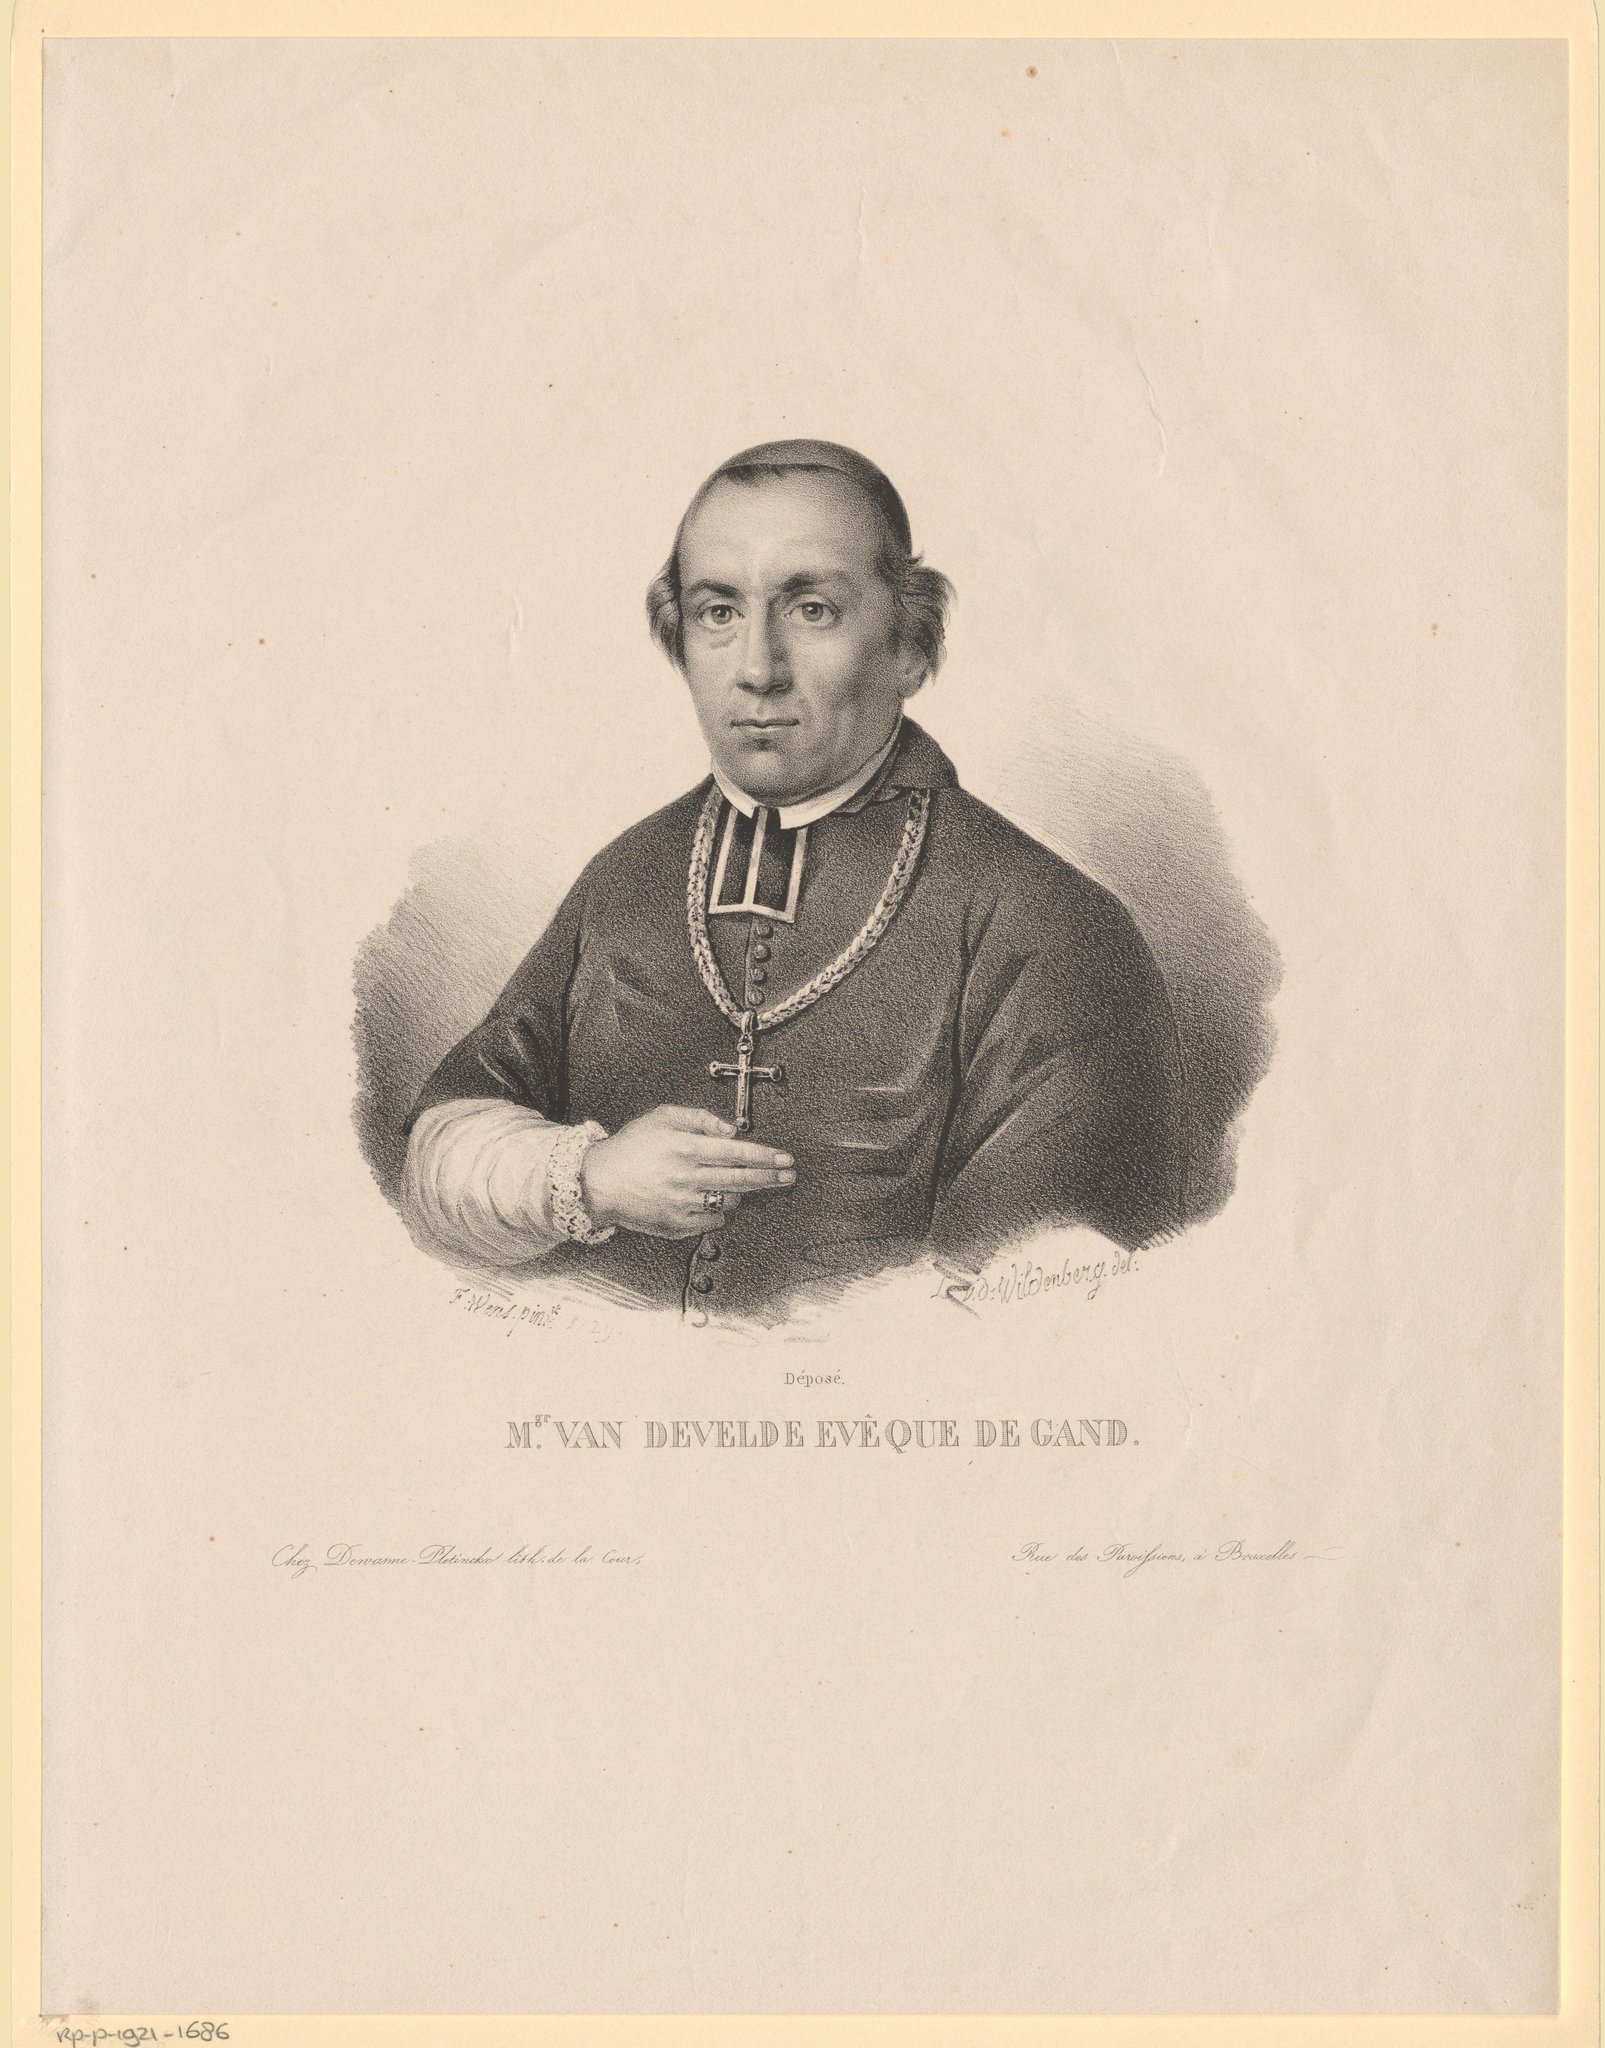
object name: print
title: Portret van Jan Frans Van de Velde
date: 1829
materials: paper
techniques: lithograph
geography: brussels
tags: boom, ghent, archbishop, bishop, etc. (roman catholic), historical persons